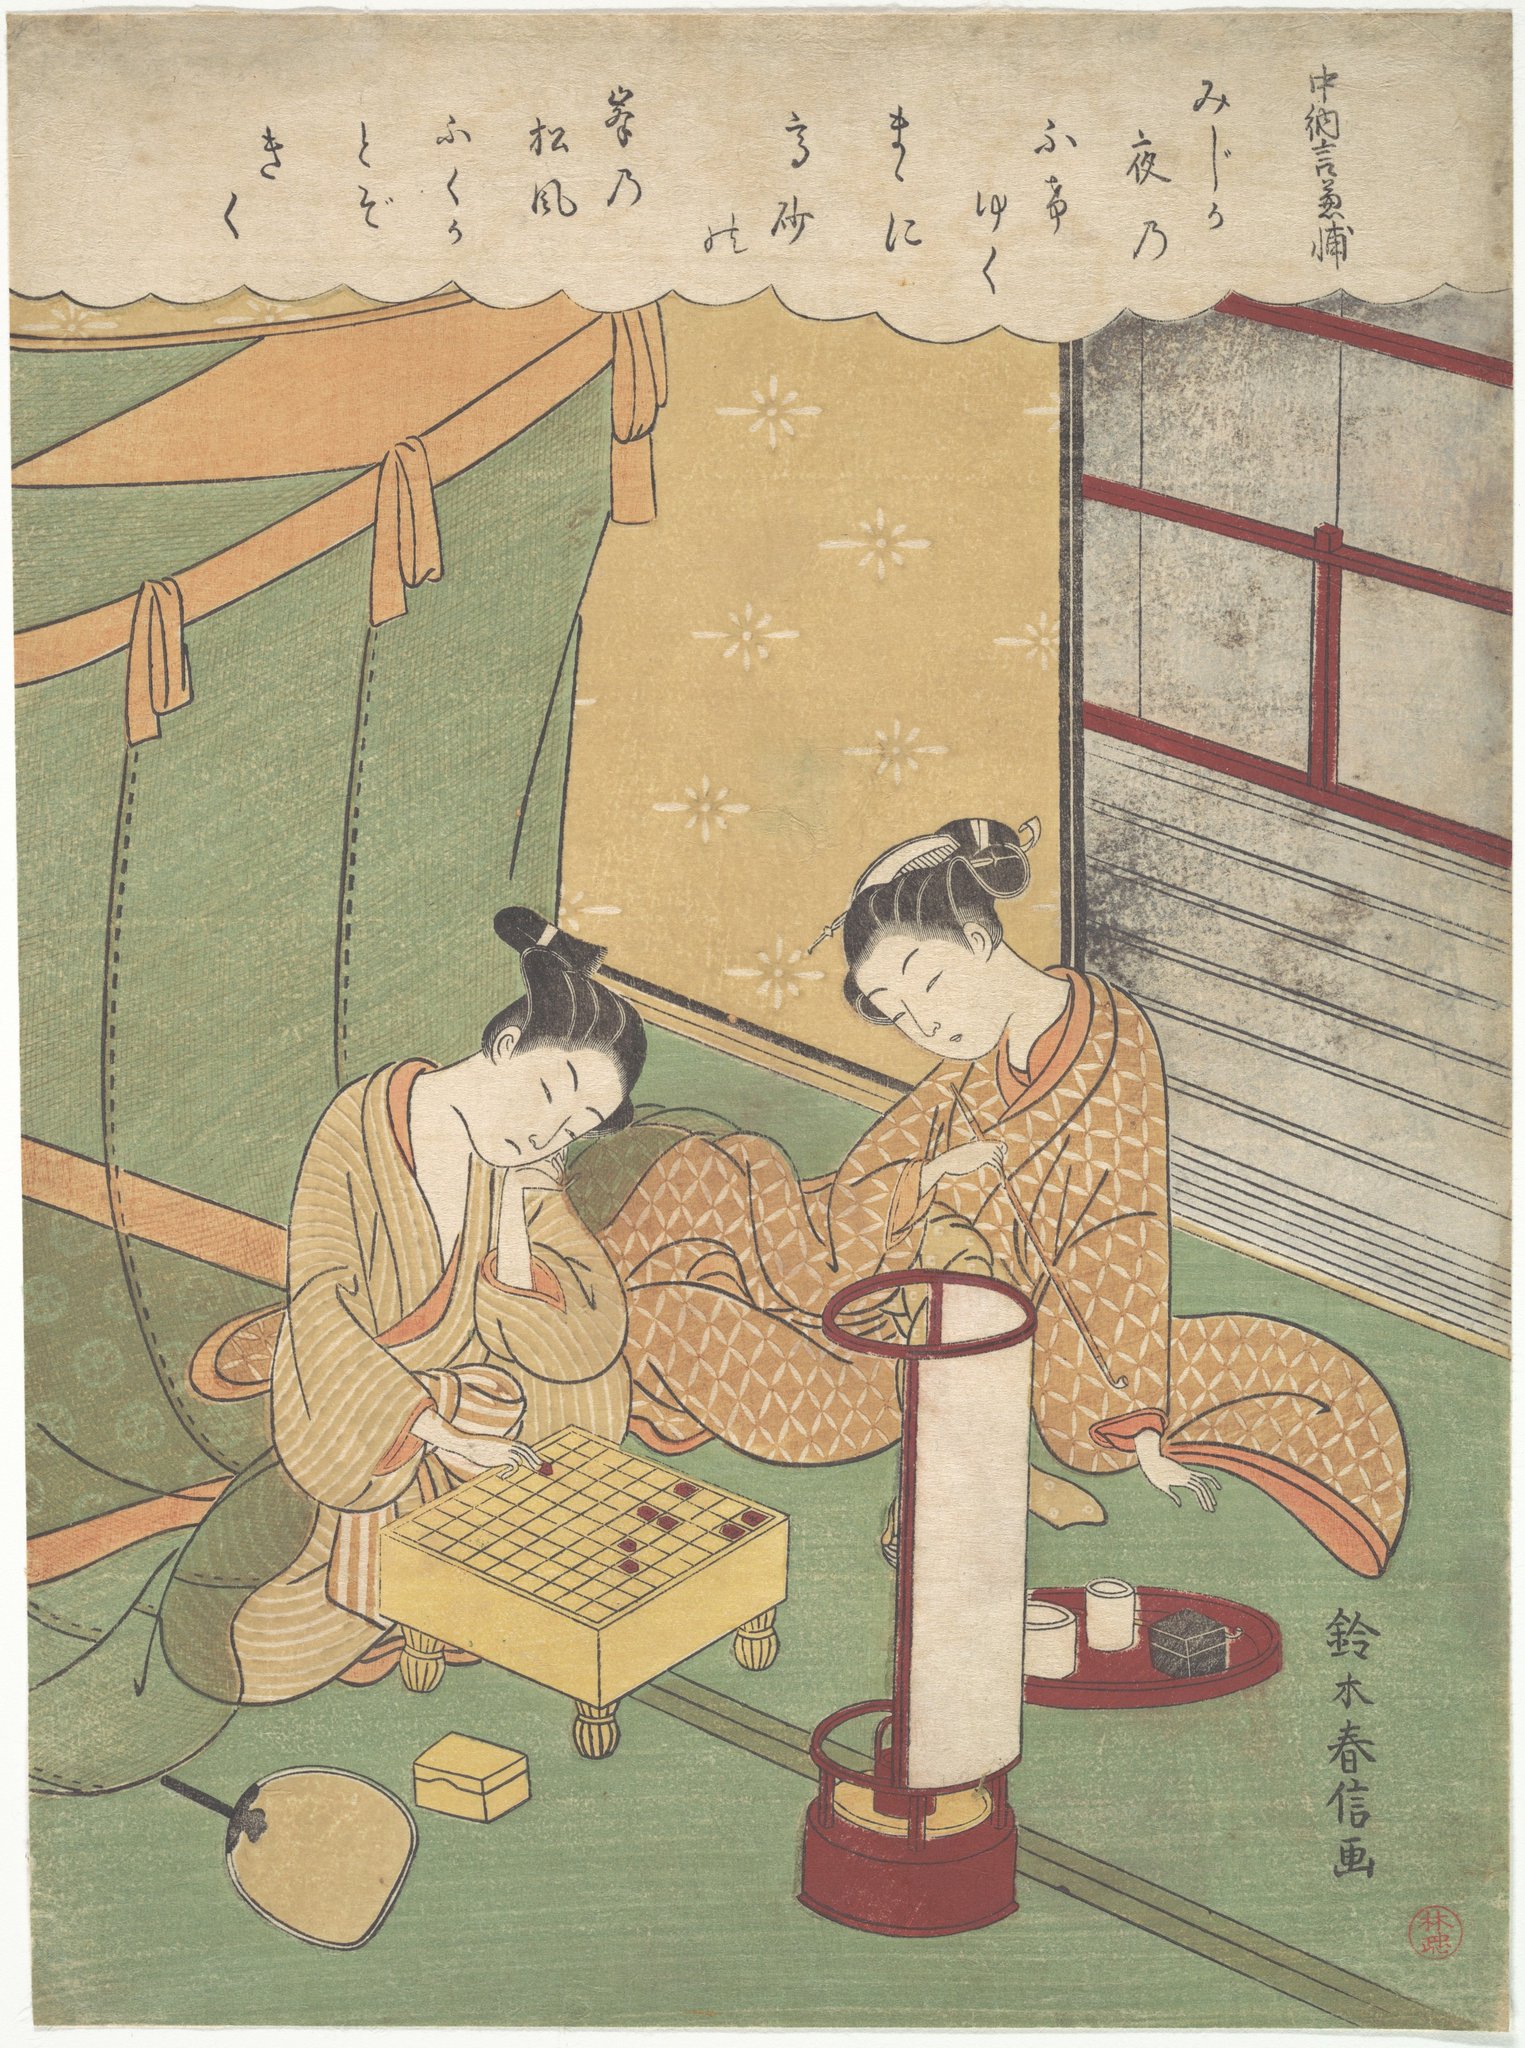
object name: print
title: A Young Woman and Man Playing Shōgi (Japanese Chess); Chūnagon Kanesuke, from a series alluding to the Thirty-Six Poetic Immortals (Sanjūrokkasen)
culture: japanese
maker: suzuki harunobu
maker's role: artist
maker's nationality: japanese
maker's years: 1725-1770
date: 1767-1769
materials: ink, paper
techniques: woodblock print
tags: men,women,chess,games